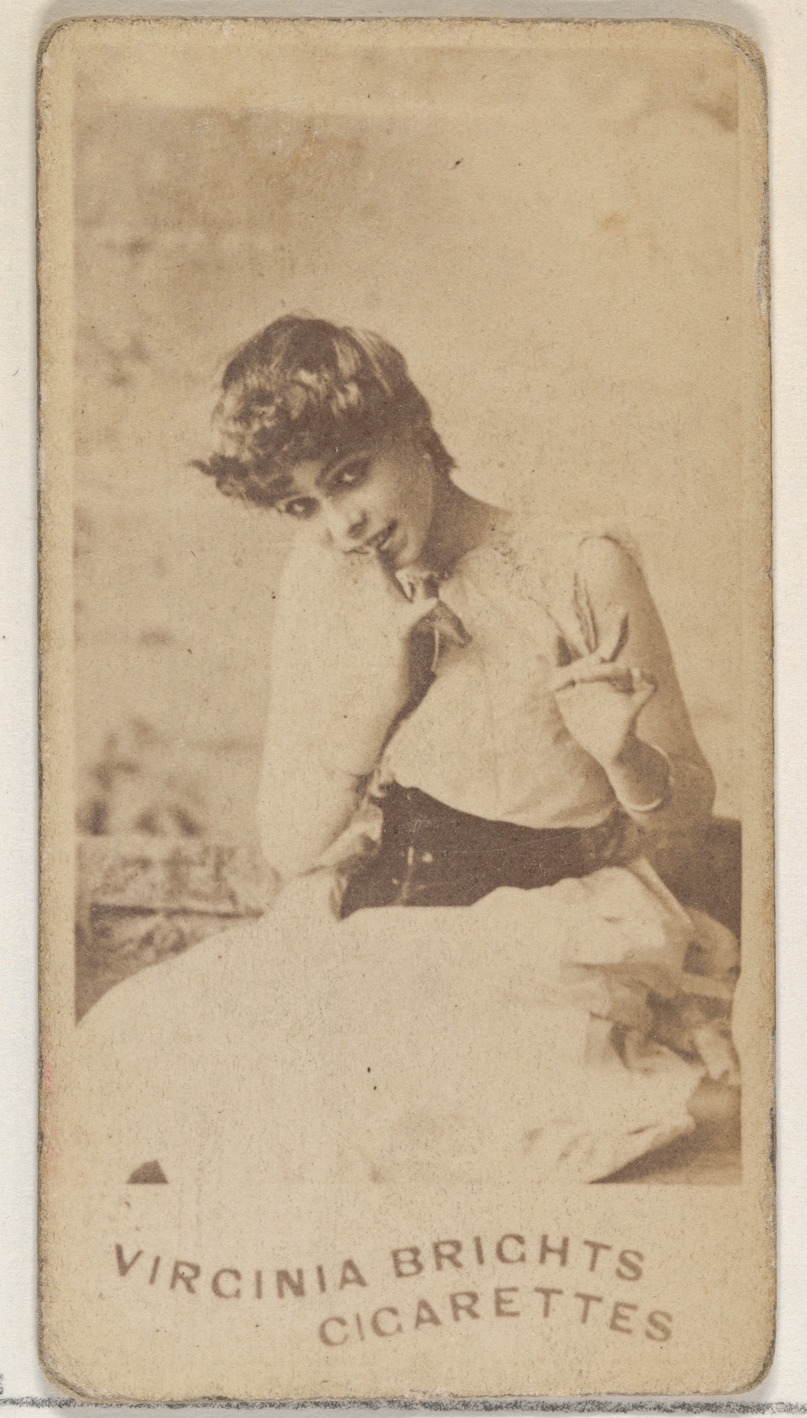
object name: photograph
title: From the Actors and Actresses series (N45, Type 5) for Virginia Brights Cigarettes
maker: allen & ginter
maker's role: publisher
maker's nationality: american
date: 1888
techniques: albumen silver print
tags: portraits,women,actresses